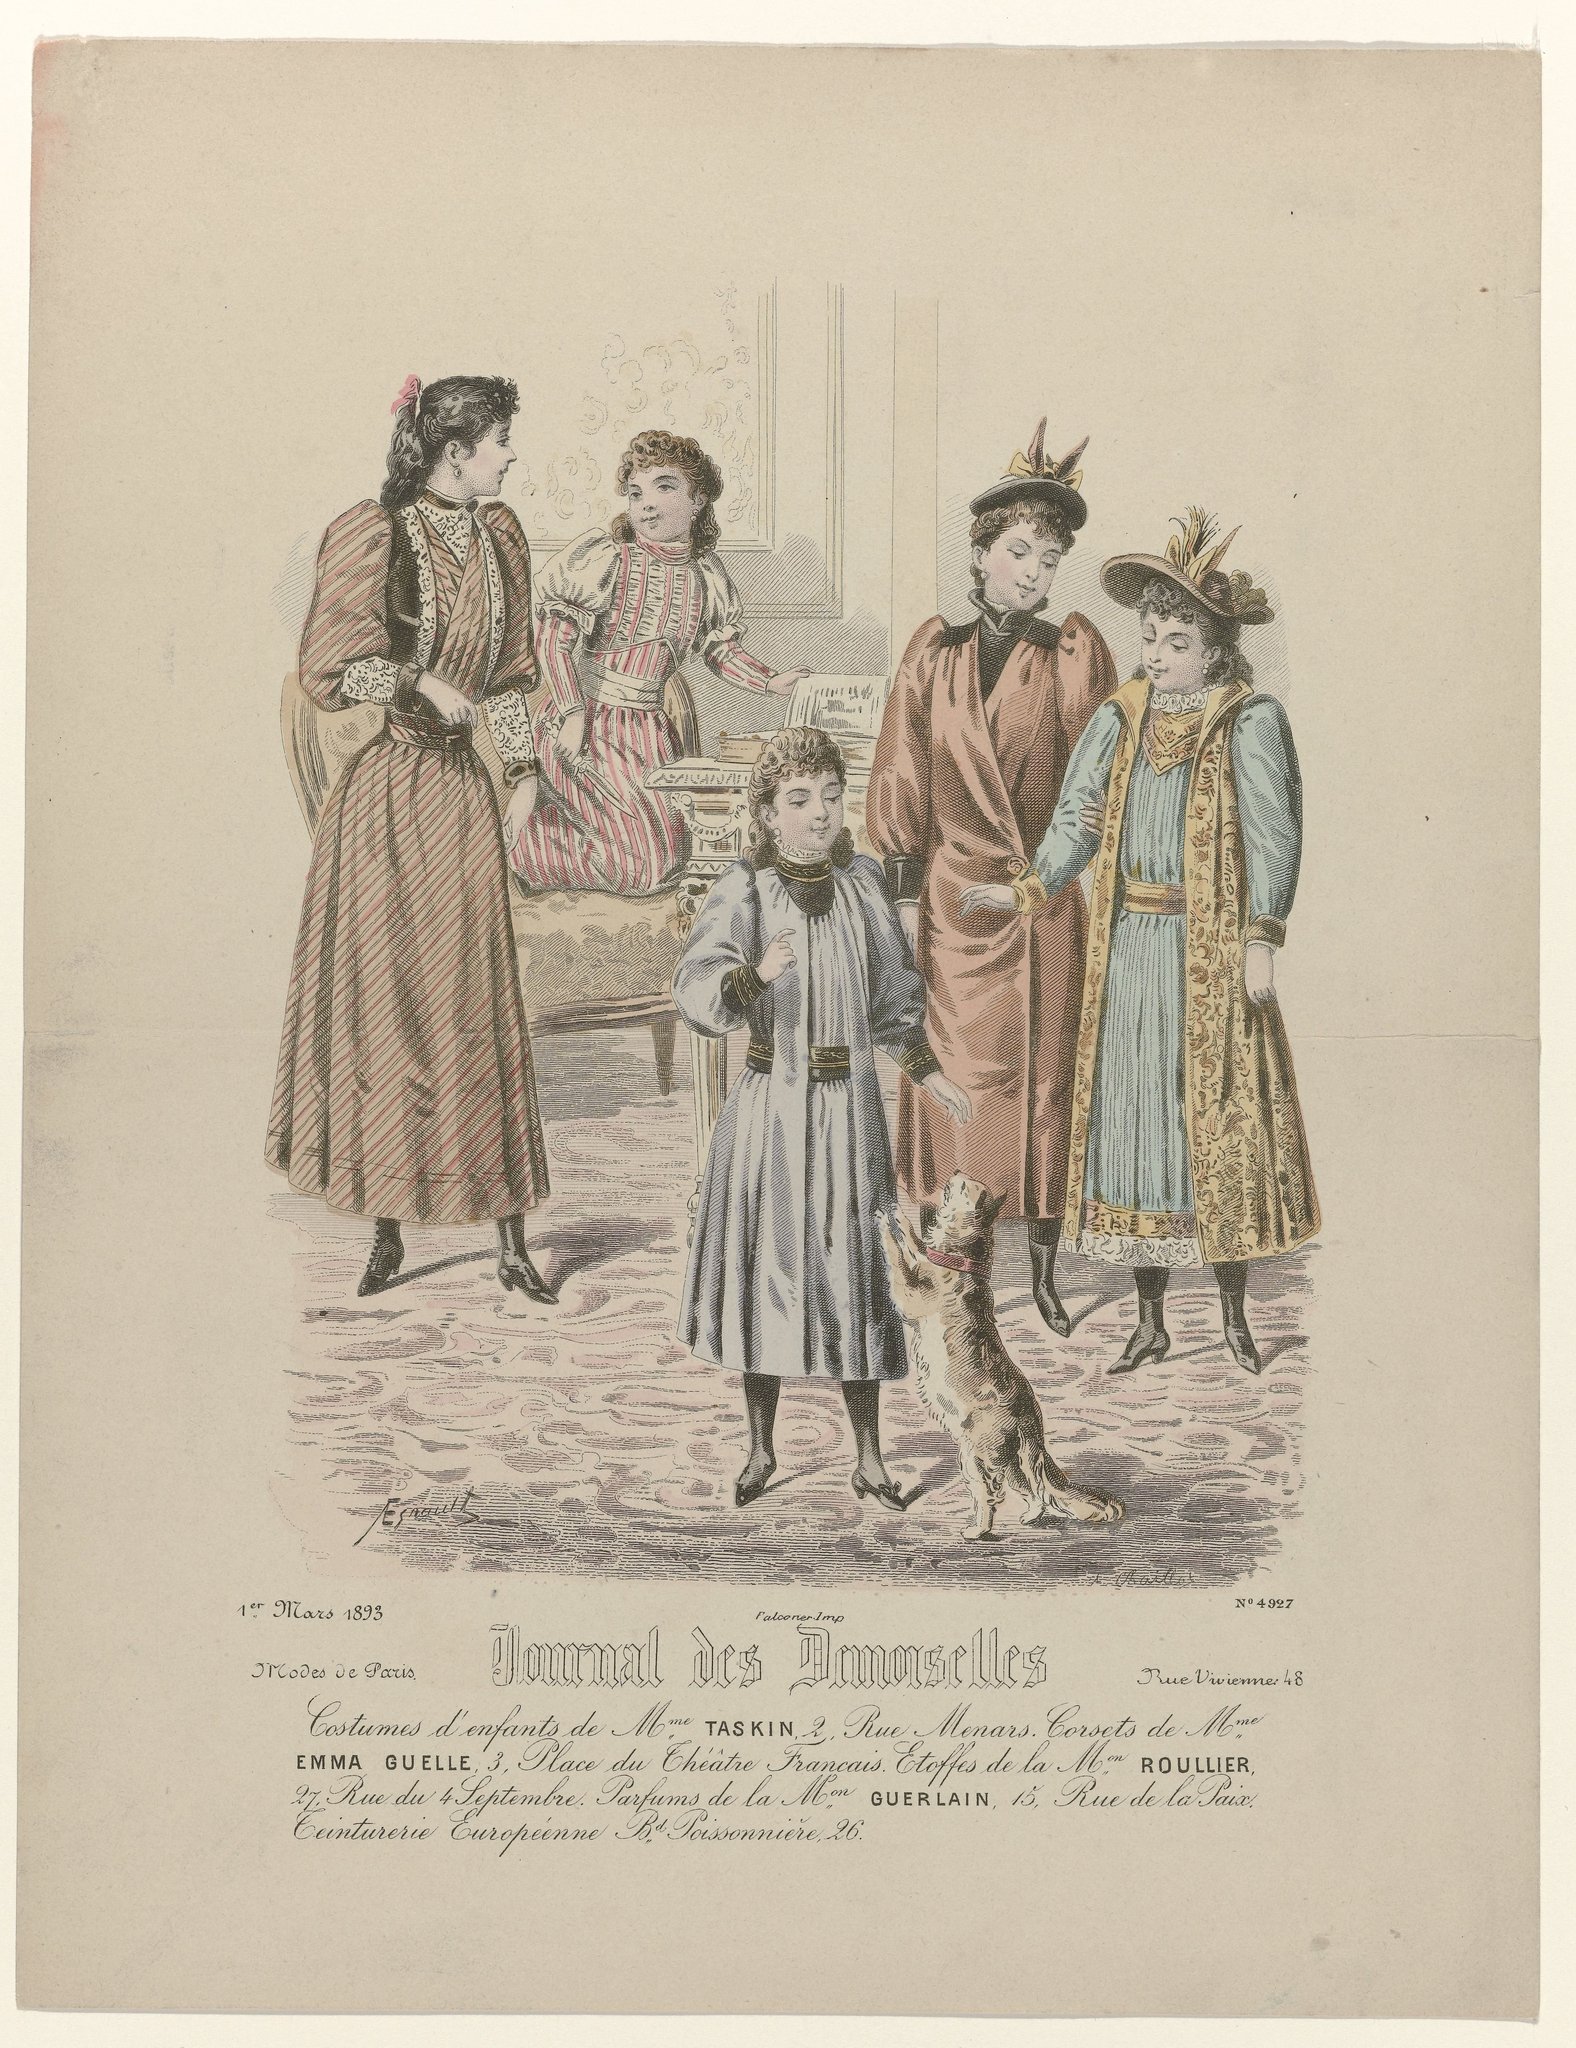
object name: fashion print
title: Journal des Demoiselles, 1 mars 1893, No. 4927 : Costuems d'enfants (...)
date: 1893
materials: paper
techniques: engraving, hand coloring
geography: paris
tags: head-gear (+ girls' clothes), shoes, sandals (+ girls' clothes), boots (+ girls' clothes), ear-rings (+ girls' clothes), fashion plates, dog, dress, gown (+ girls' clothes)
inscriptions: address: ‘Modes de Paris / Rue Vivienne 48’, caption: ‘Costumes d'enfants de M.me Taskin, 2, Rue Menars. Corsets de M.me Emma Guelle, 3, Place du Théâtre Français. Etoffes de la M.on Roullier, 27, Rue du 4 Septembre. Parfums de la M.on Guerlain, 15 Rue de la Paix. Teinturerie Européenne B.d Poissonniere, 26.’, title: ‘Journal des Demoiselles’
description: Vijf meisjes in een intererieur. Volgens het onderschrift: kinderkleding van Taskin. Hieronder enkele regels reclametekst voor verschillende producten. Prent uit het modetijdschrift Journal des Demoiselles (1833 -1922).